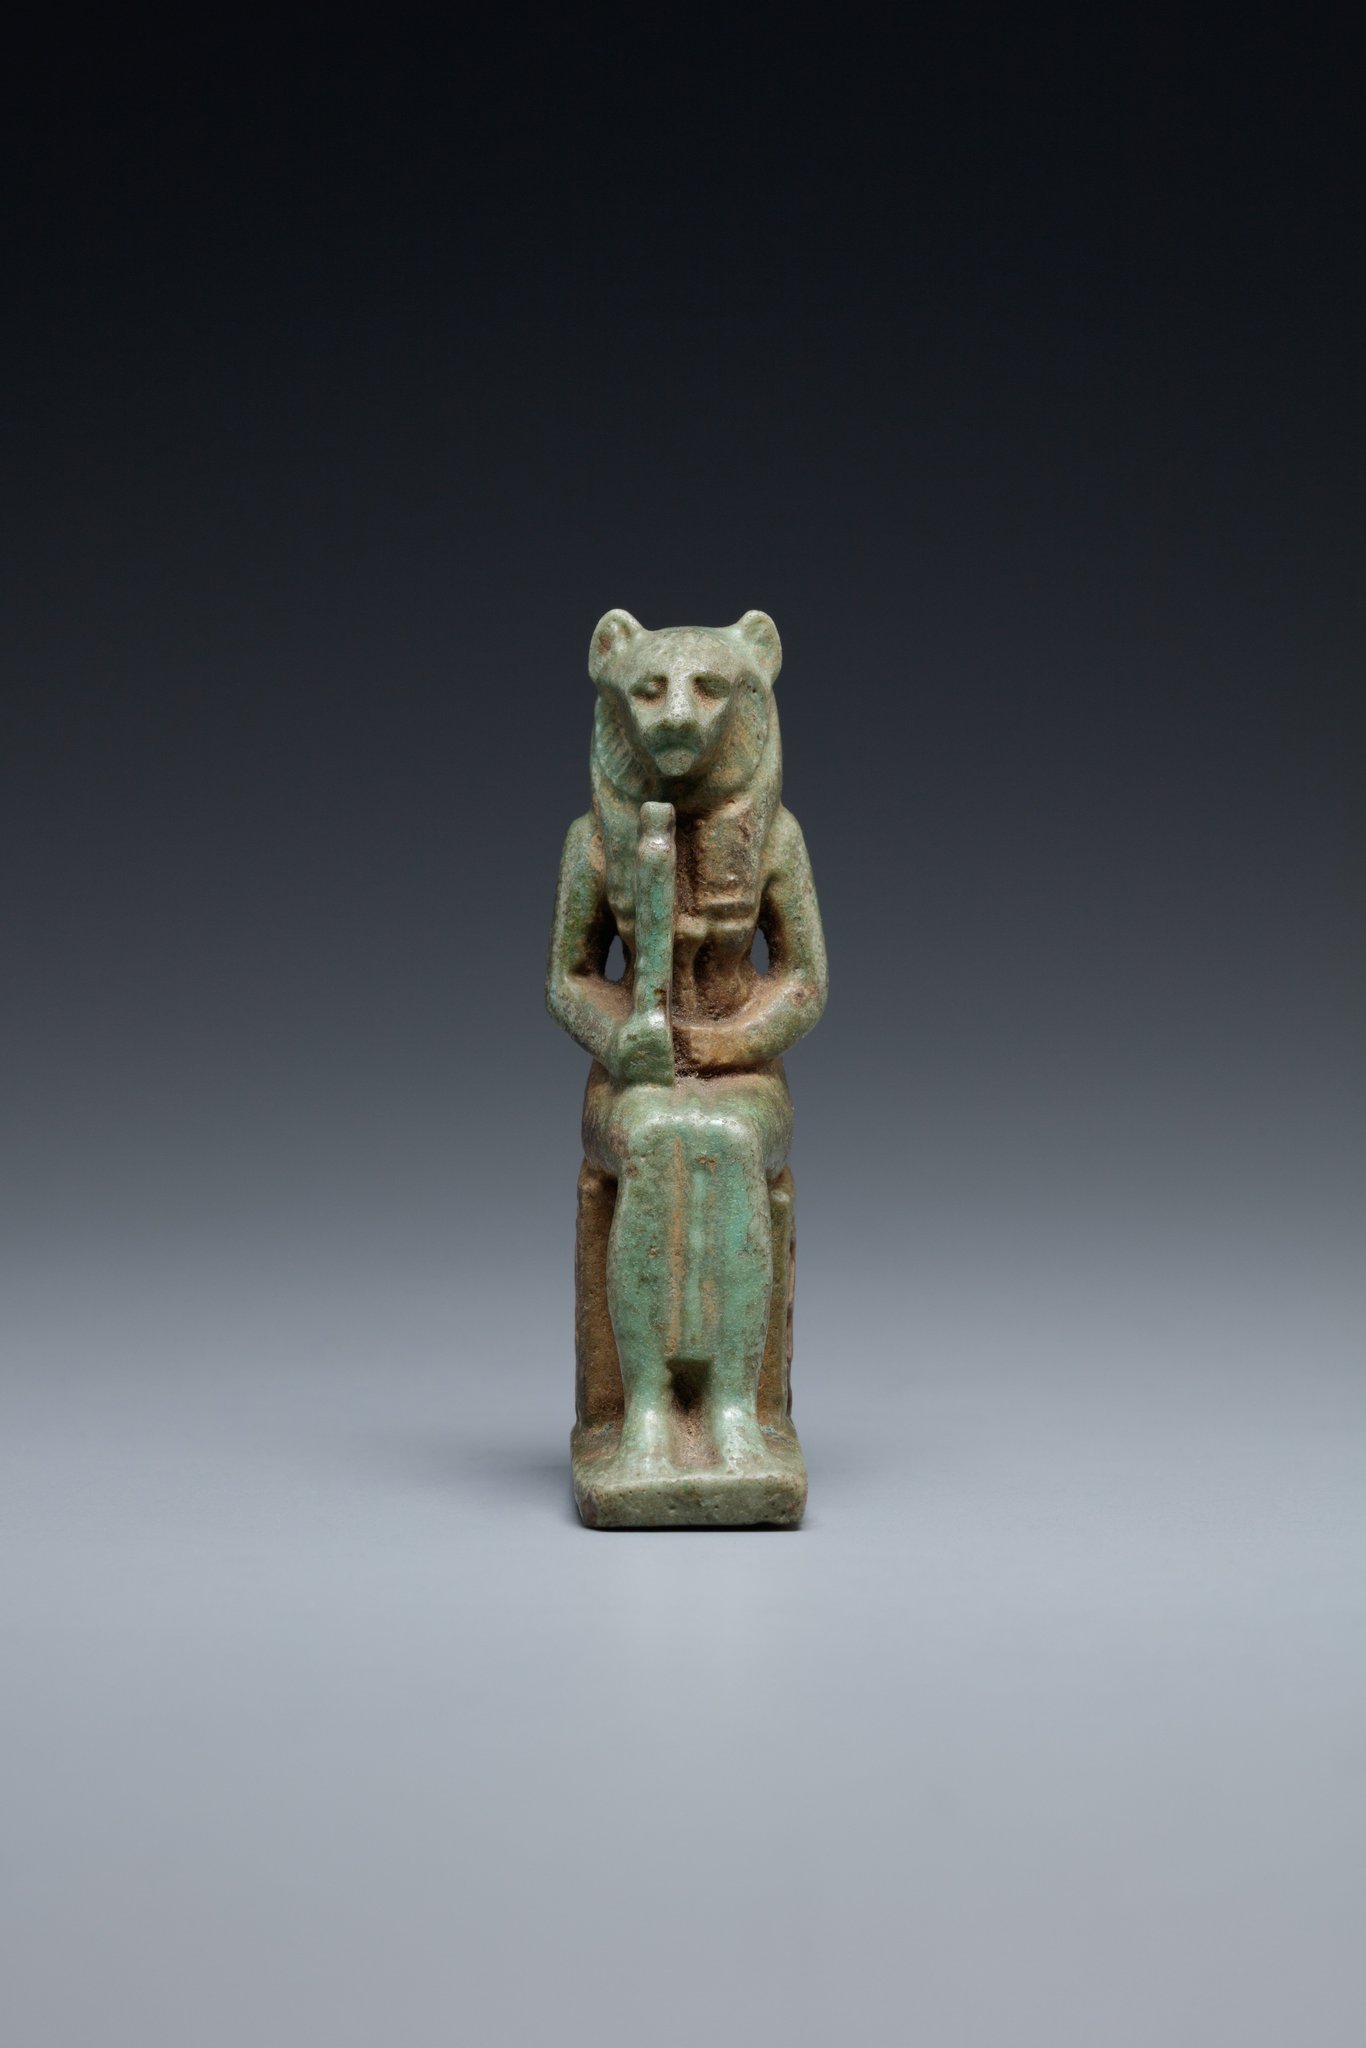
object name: amulet, sakhmet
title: Sakhmet Amulet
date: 664-630 BCE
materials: faience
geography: egypt